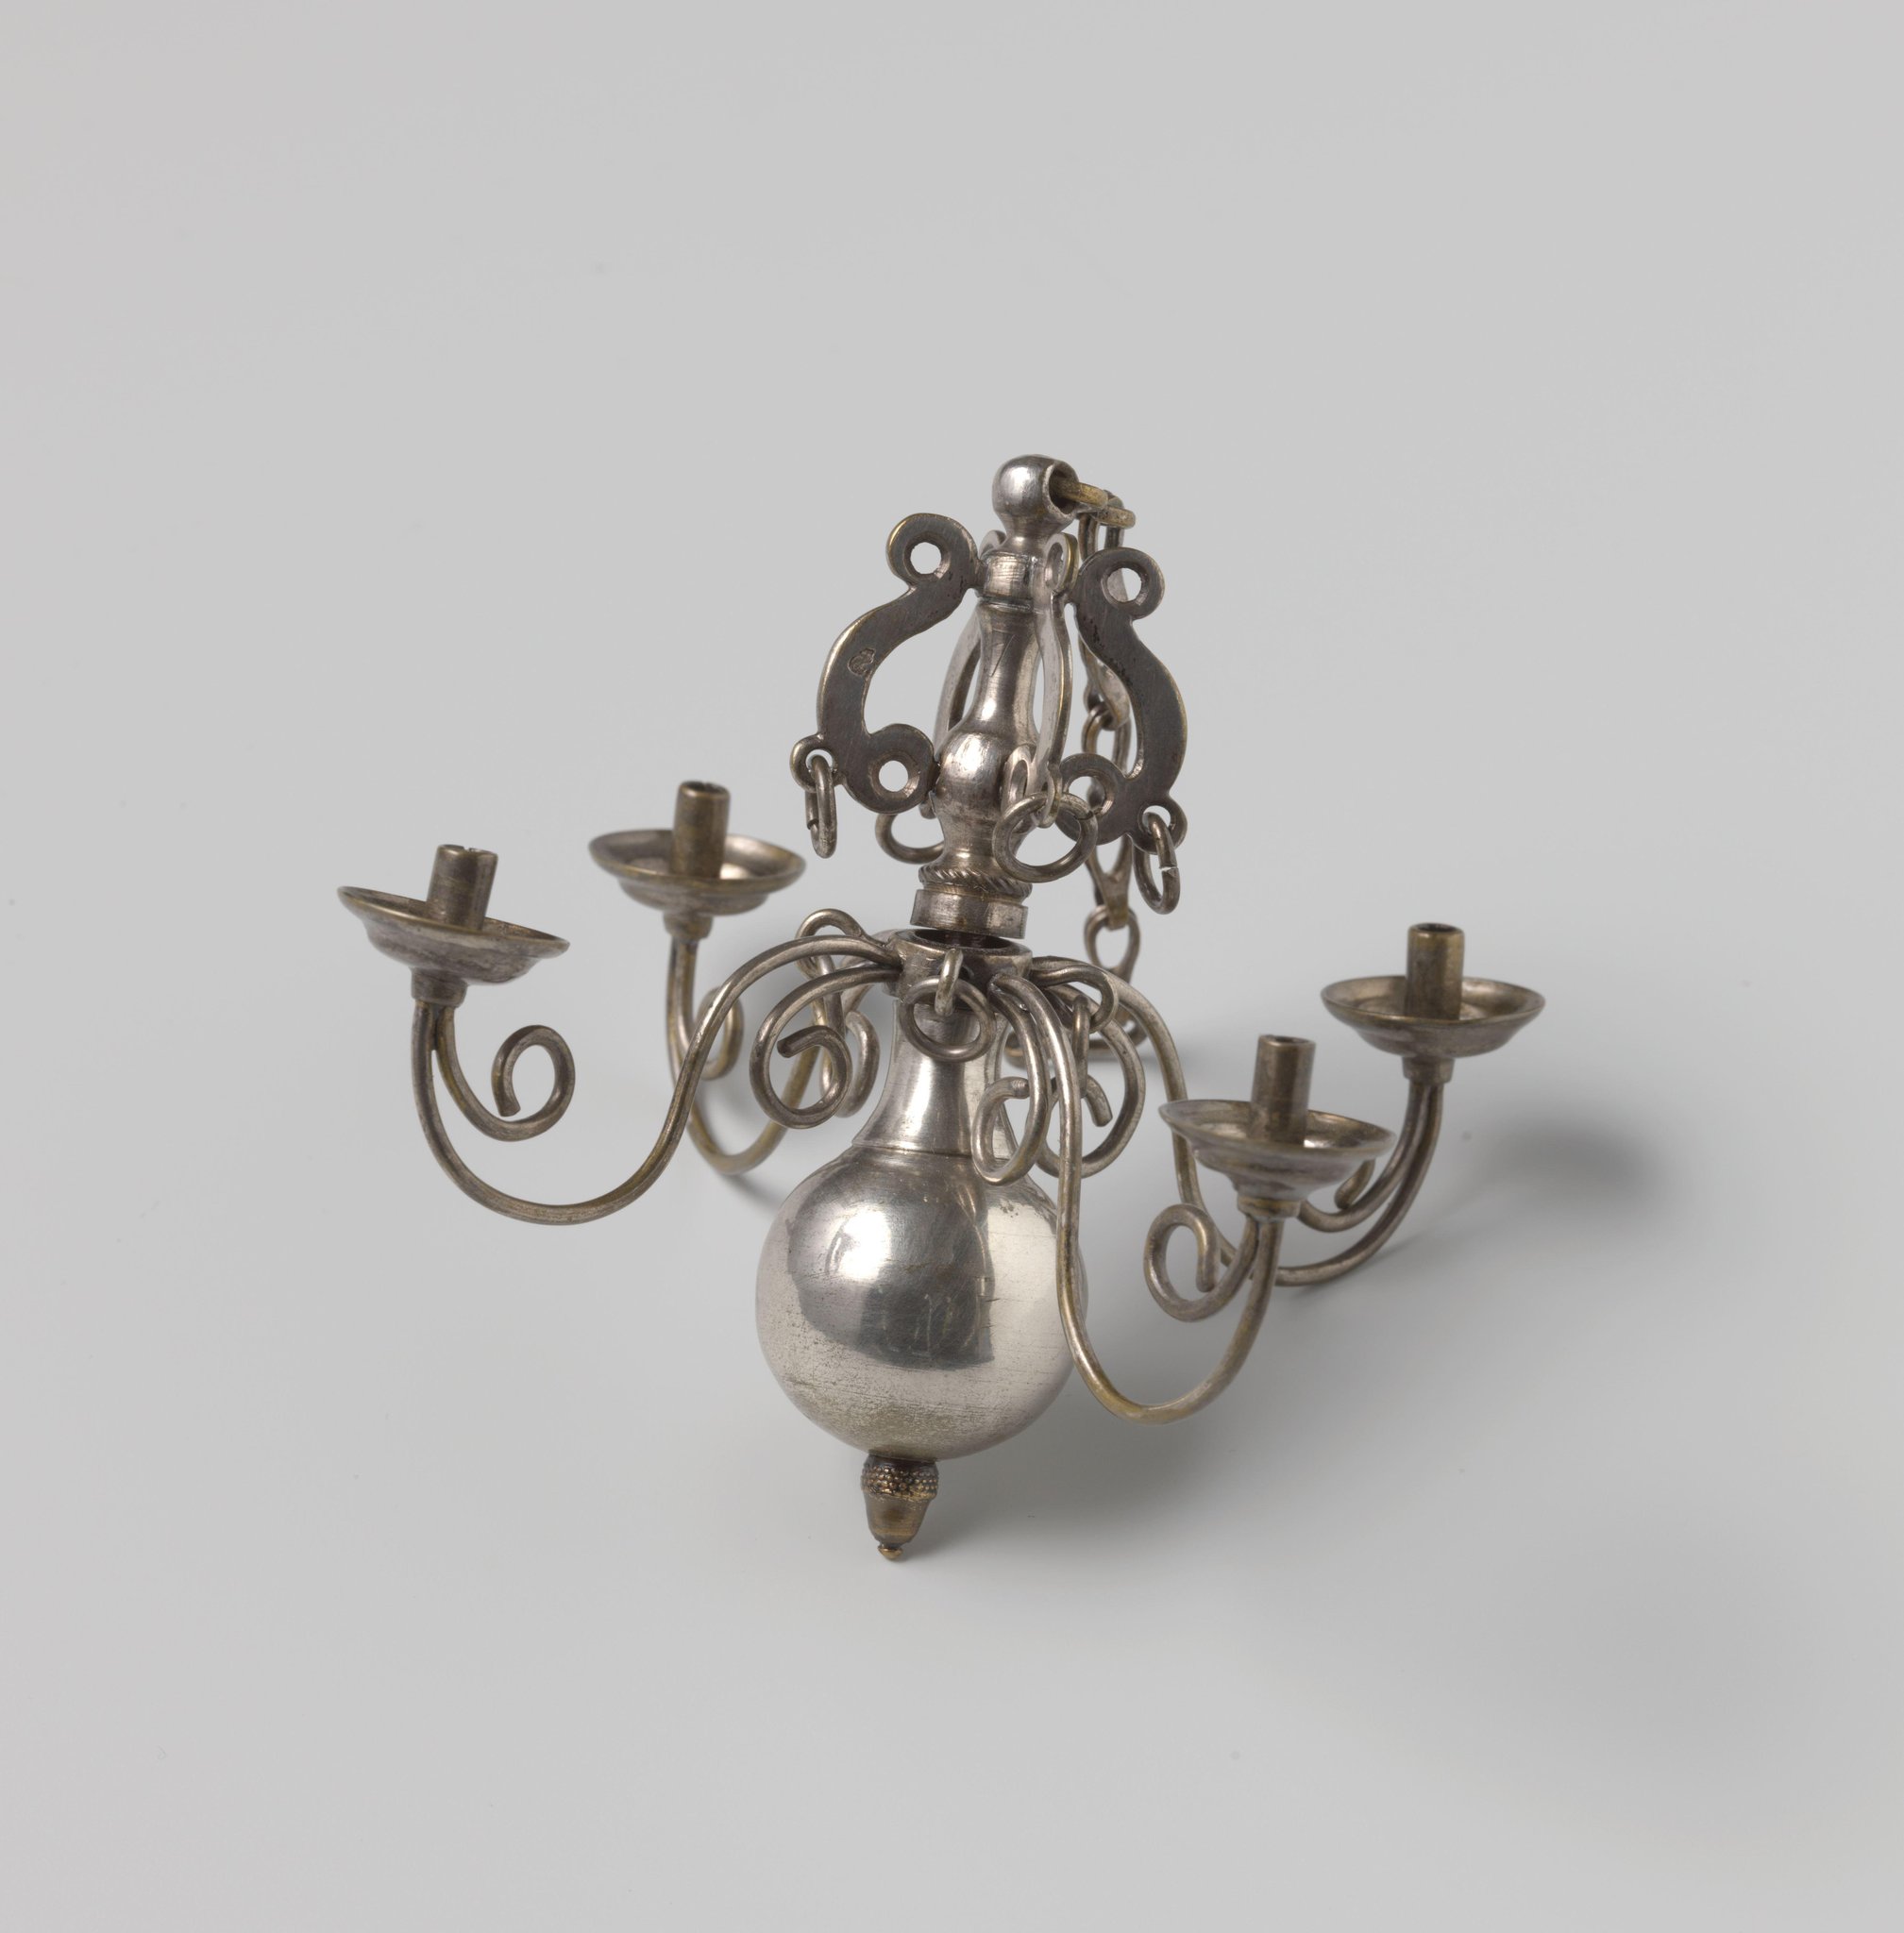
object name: miniature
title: Kaarsenkroon voor vier kaarsen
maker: Anonymous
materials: copper, silver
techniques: silvering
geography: amsterdam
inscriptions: mark (possibly false): ‘dolfijn’